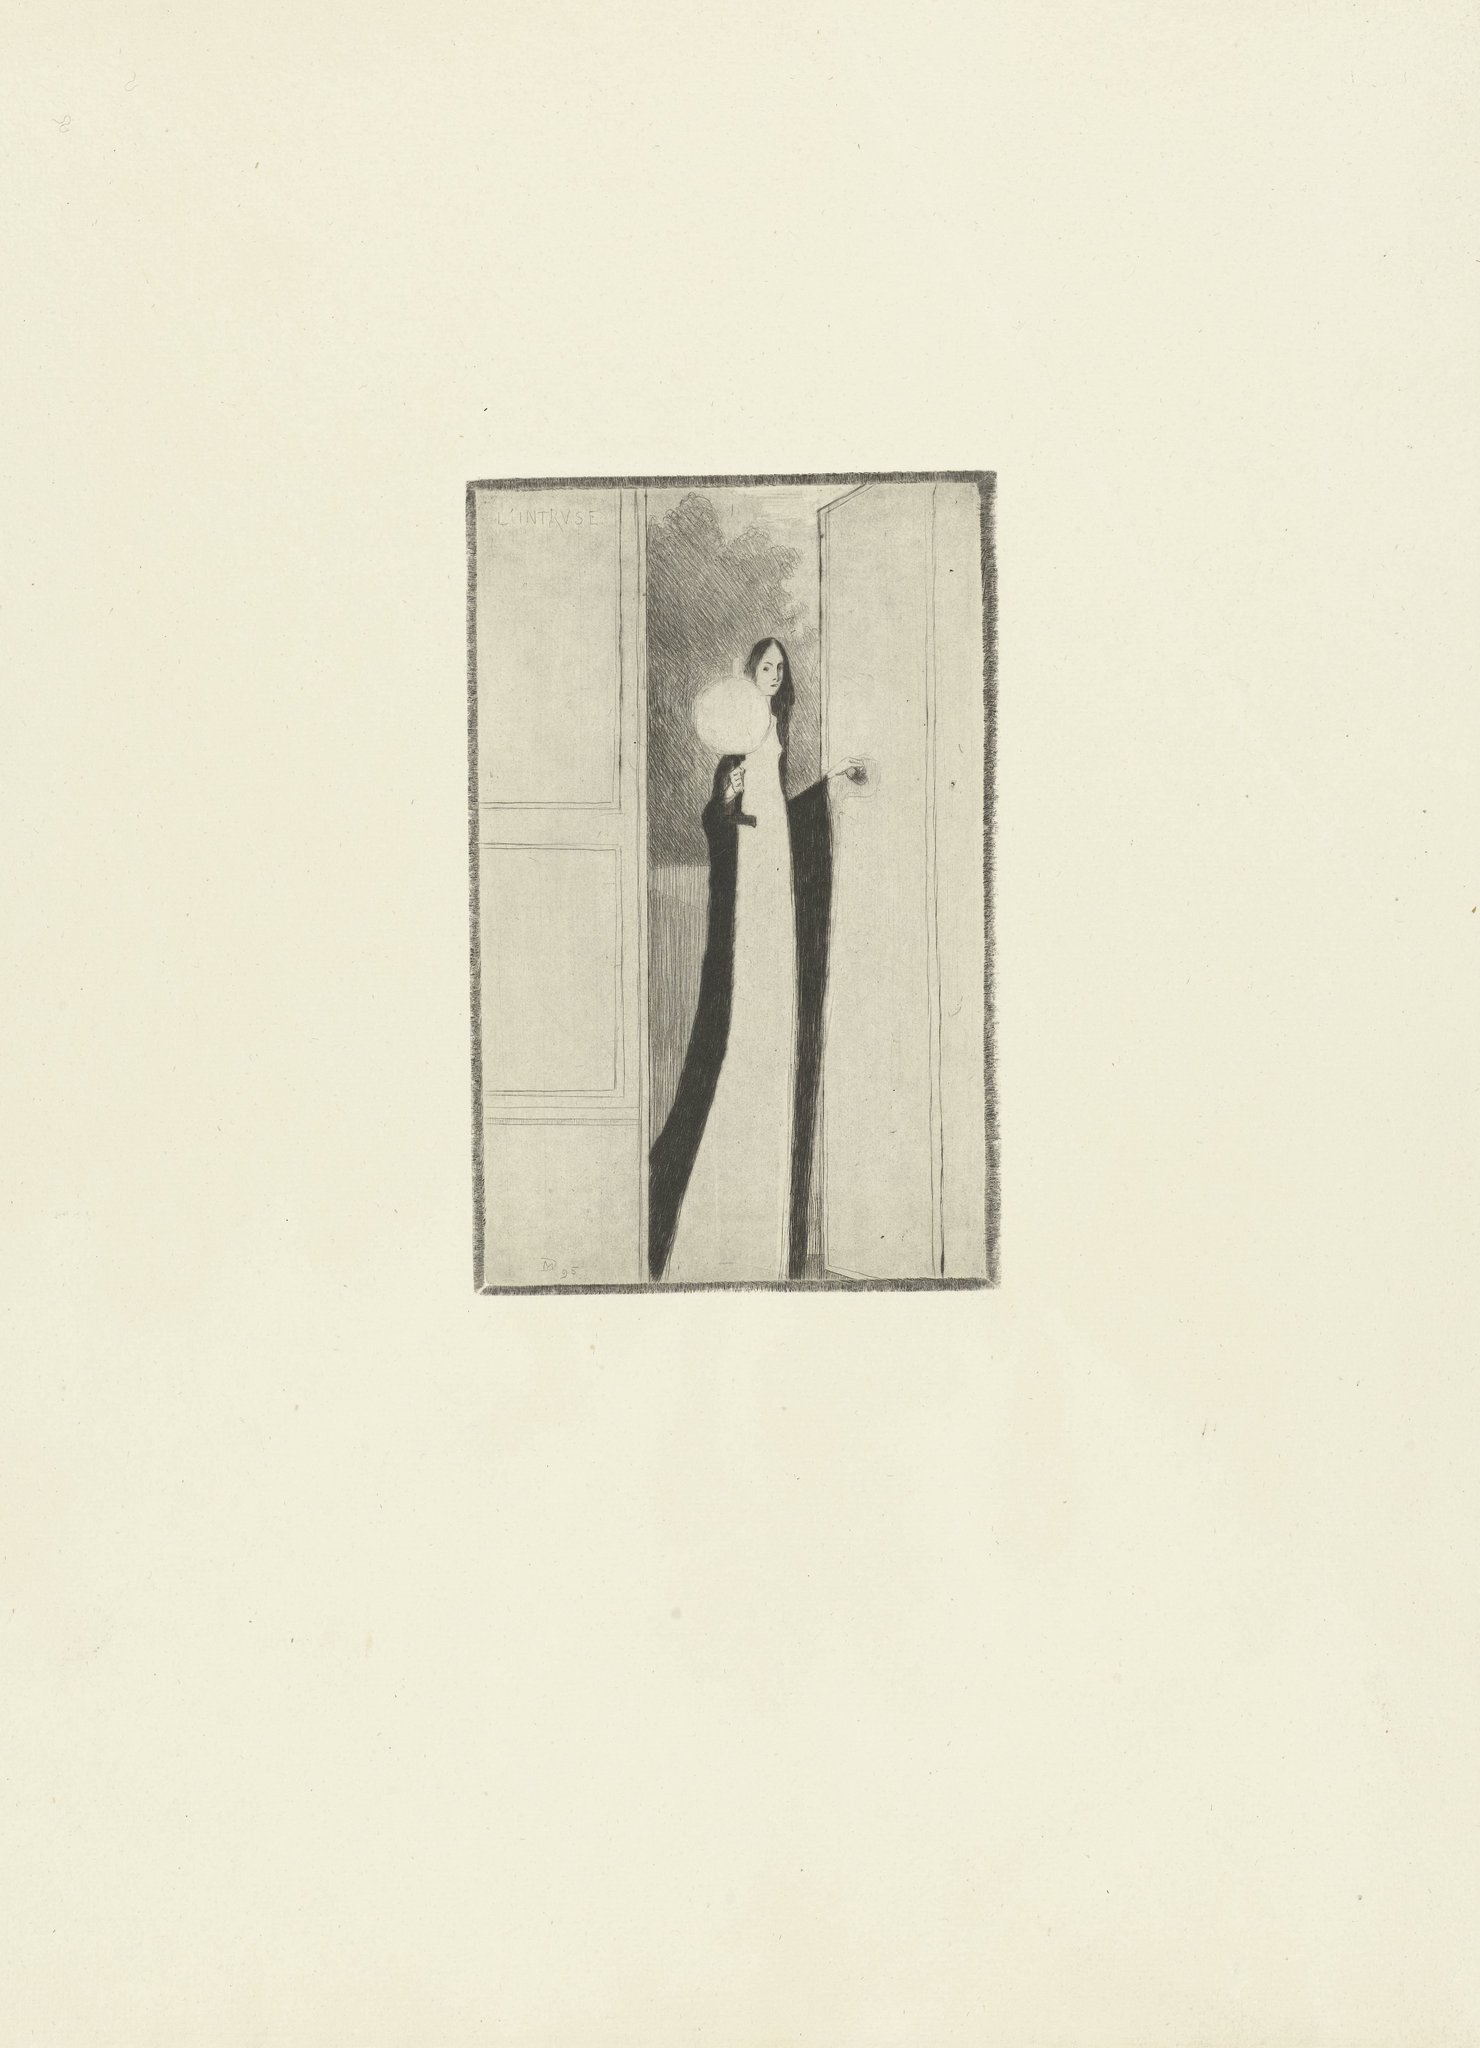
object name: print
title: Indringster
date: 1806-1895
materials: paper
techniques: drypoint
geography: paris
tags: female sex; woman, opening the door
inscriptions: collector's mark: Lugt 2228, collector's mark: Lugt 2760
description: Verschenen in album met tien originele prenten als supplement bij tijdschrift: L'Epreuve, juni 1895, prent nr. 10